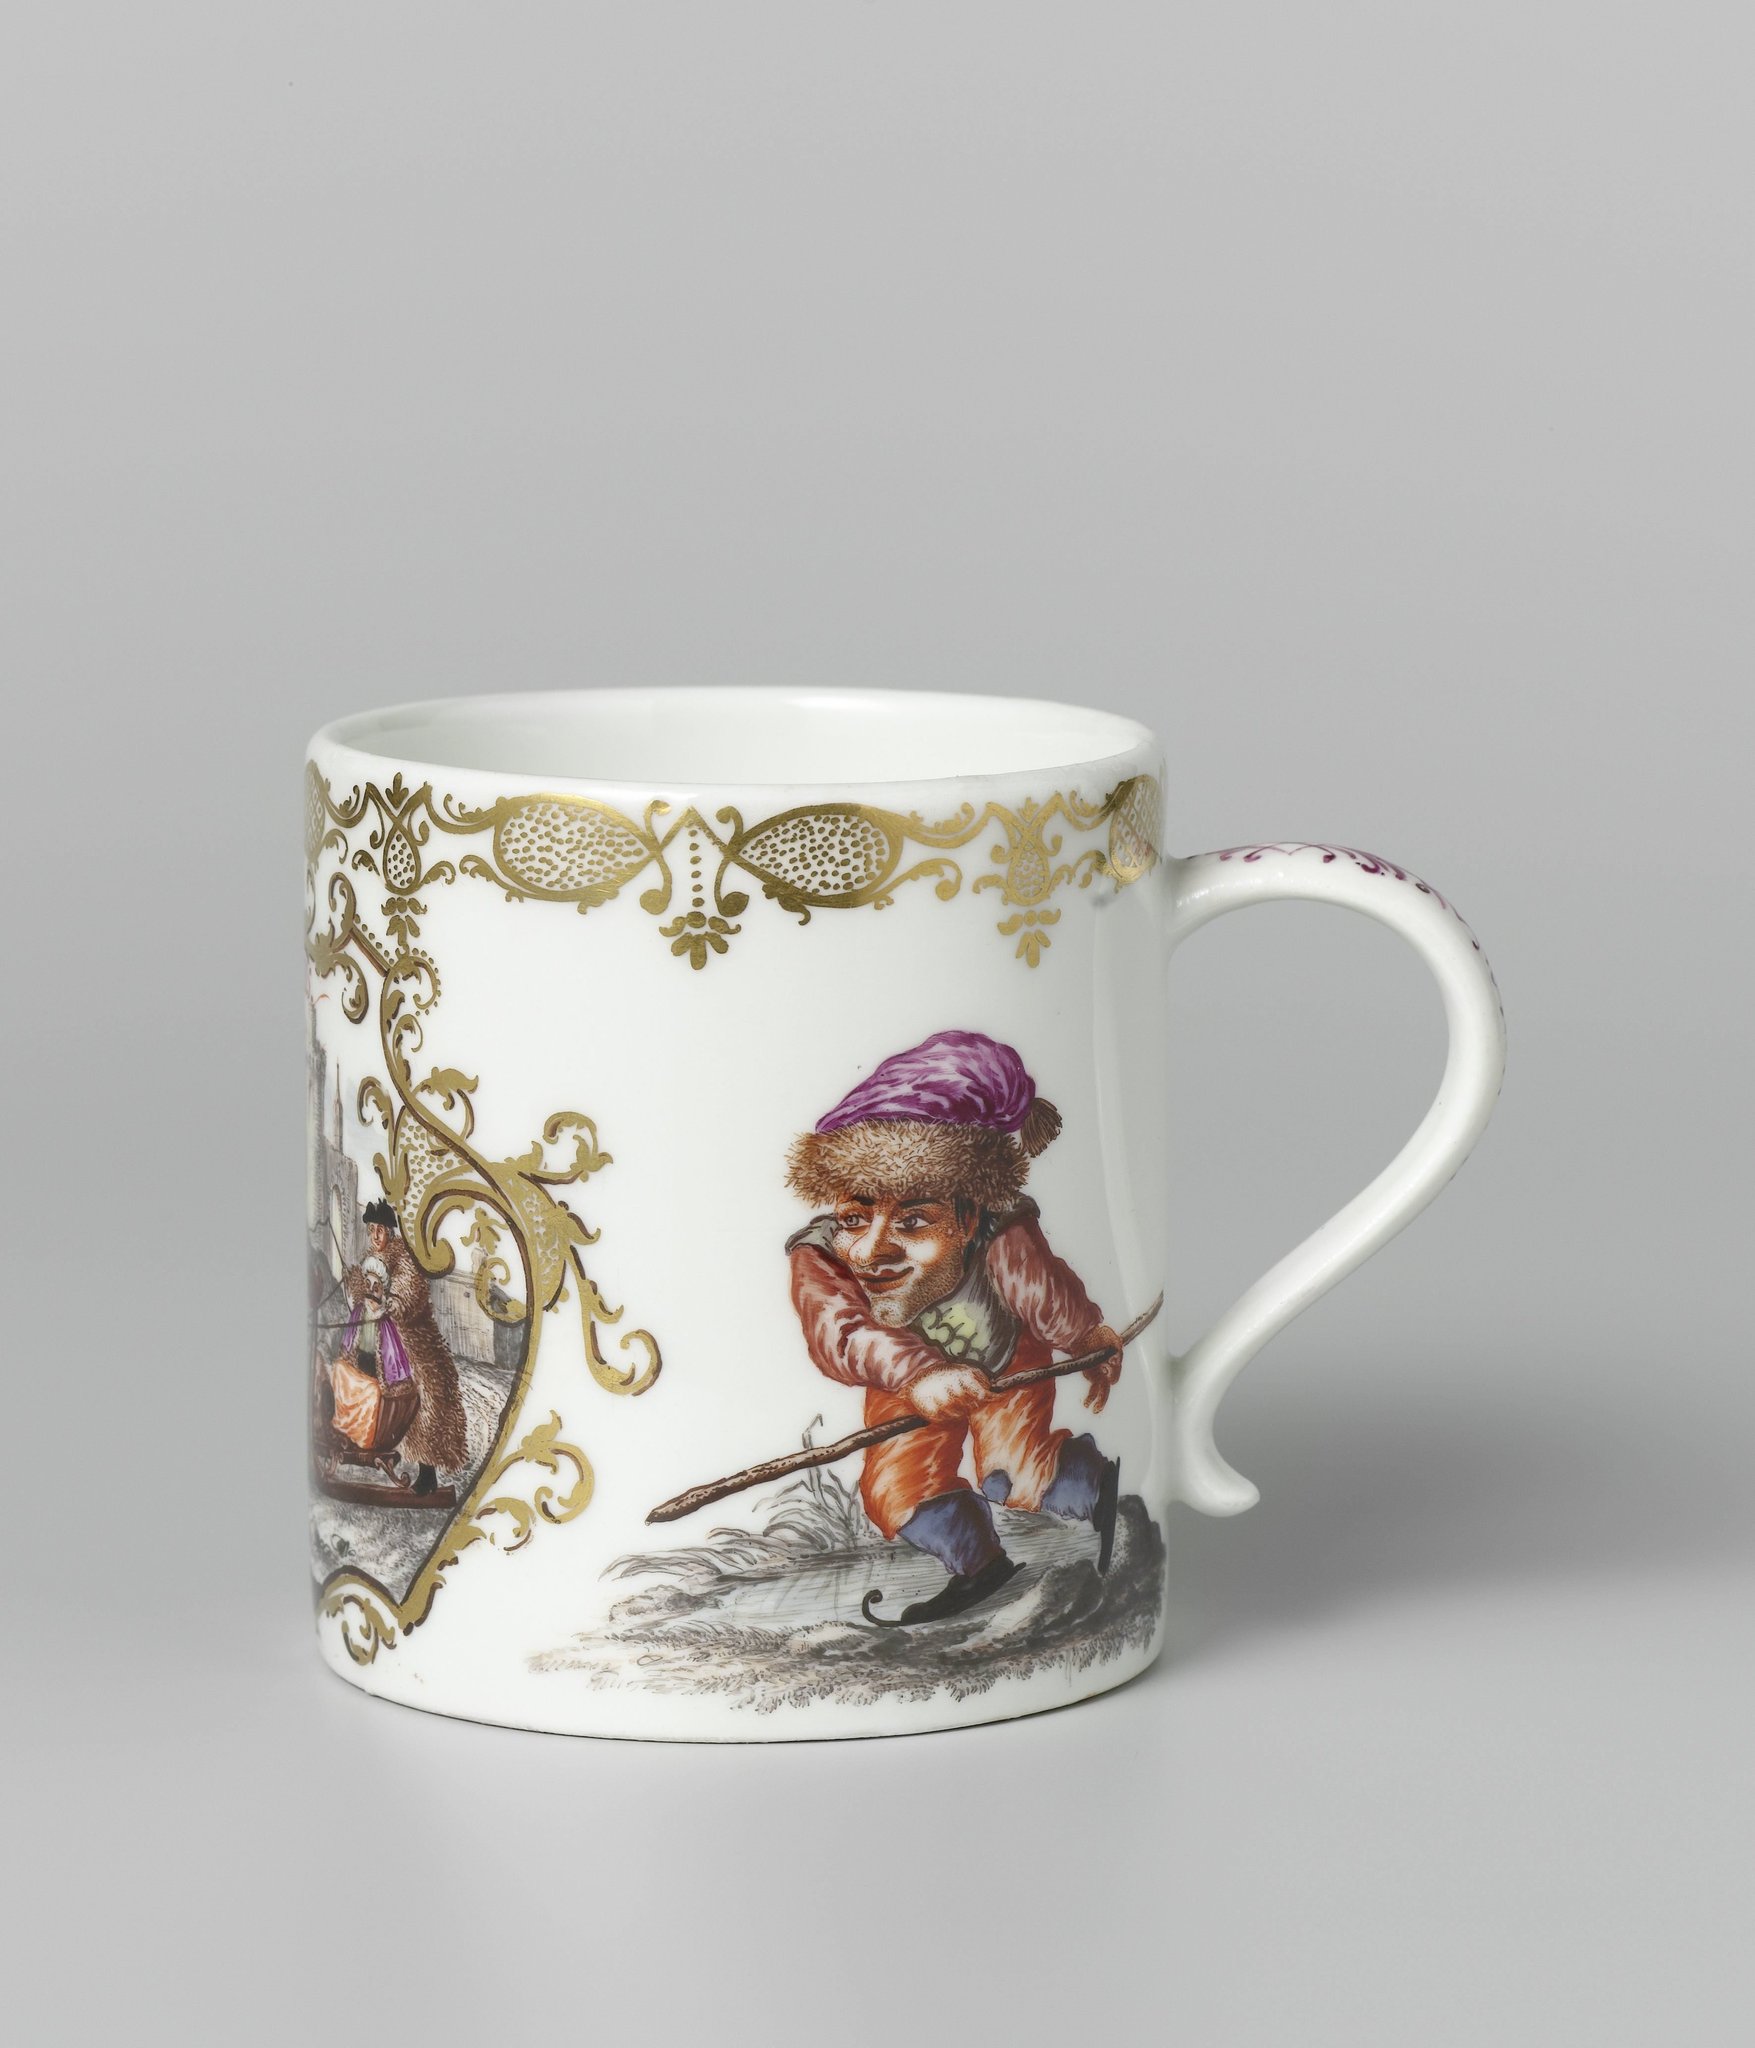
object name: cup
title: Set of mugs with the Twelve Months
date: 1740-1745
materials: porcelain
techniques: painted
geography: meissen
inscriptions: mark: ‘No: 1.’, mold mark: ‘24’, factory mark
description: Meissener Porzellan Manufaktur Meissen, c. 1740–1745 hard-paste porcelain